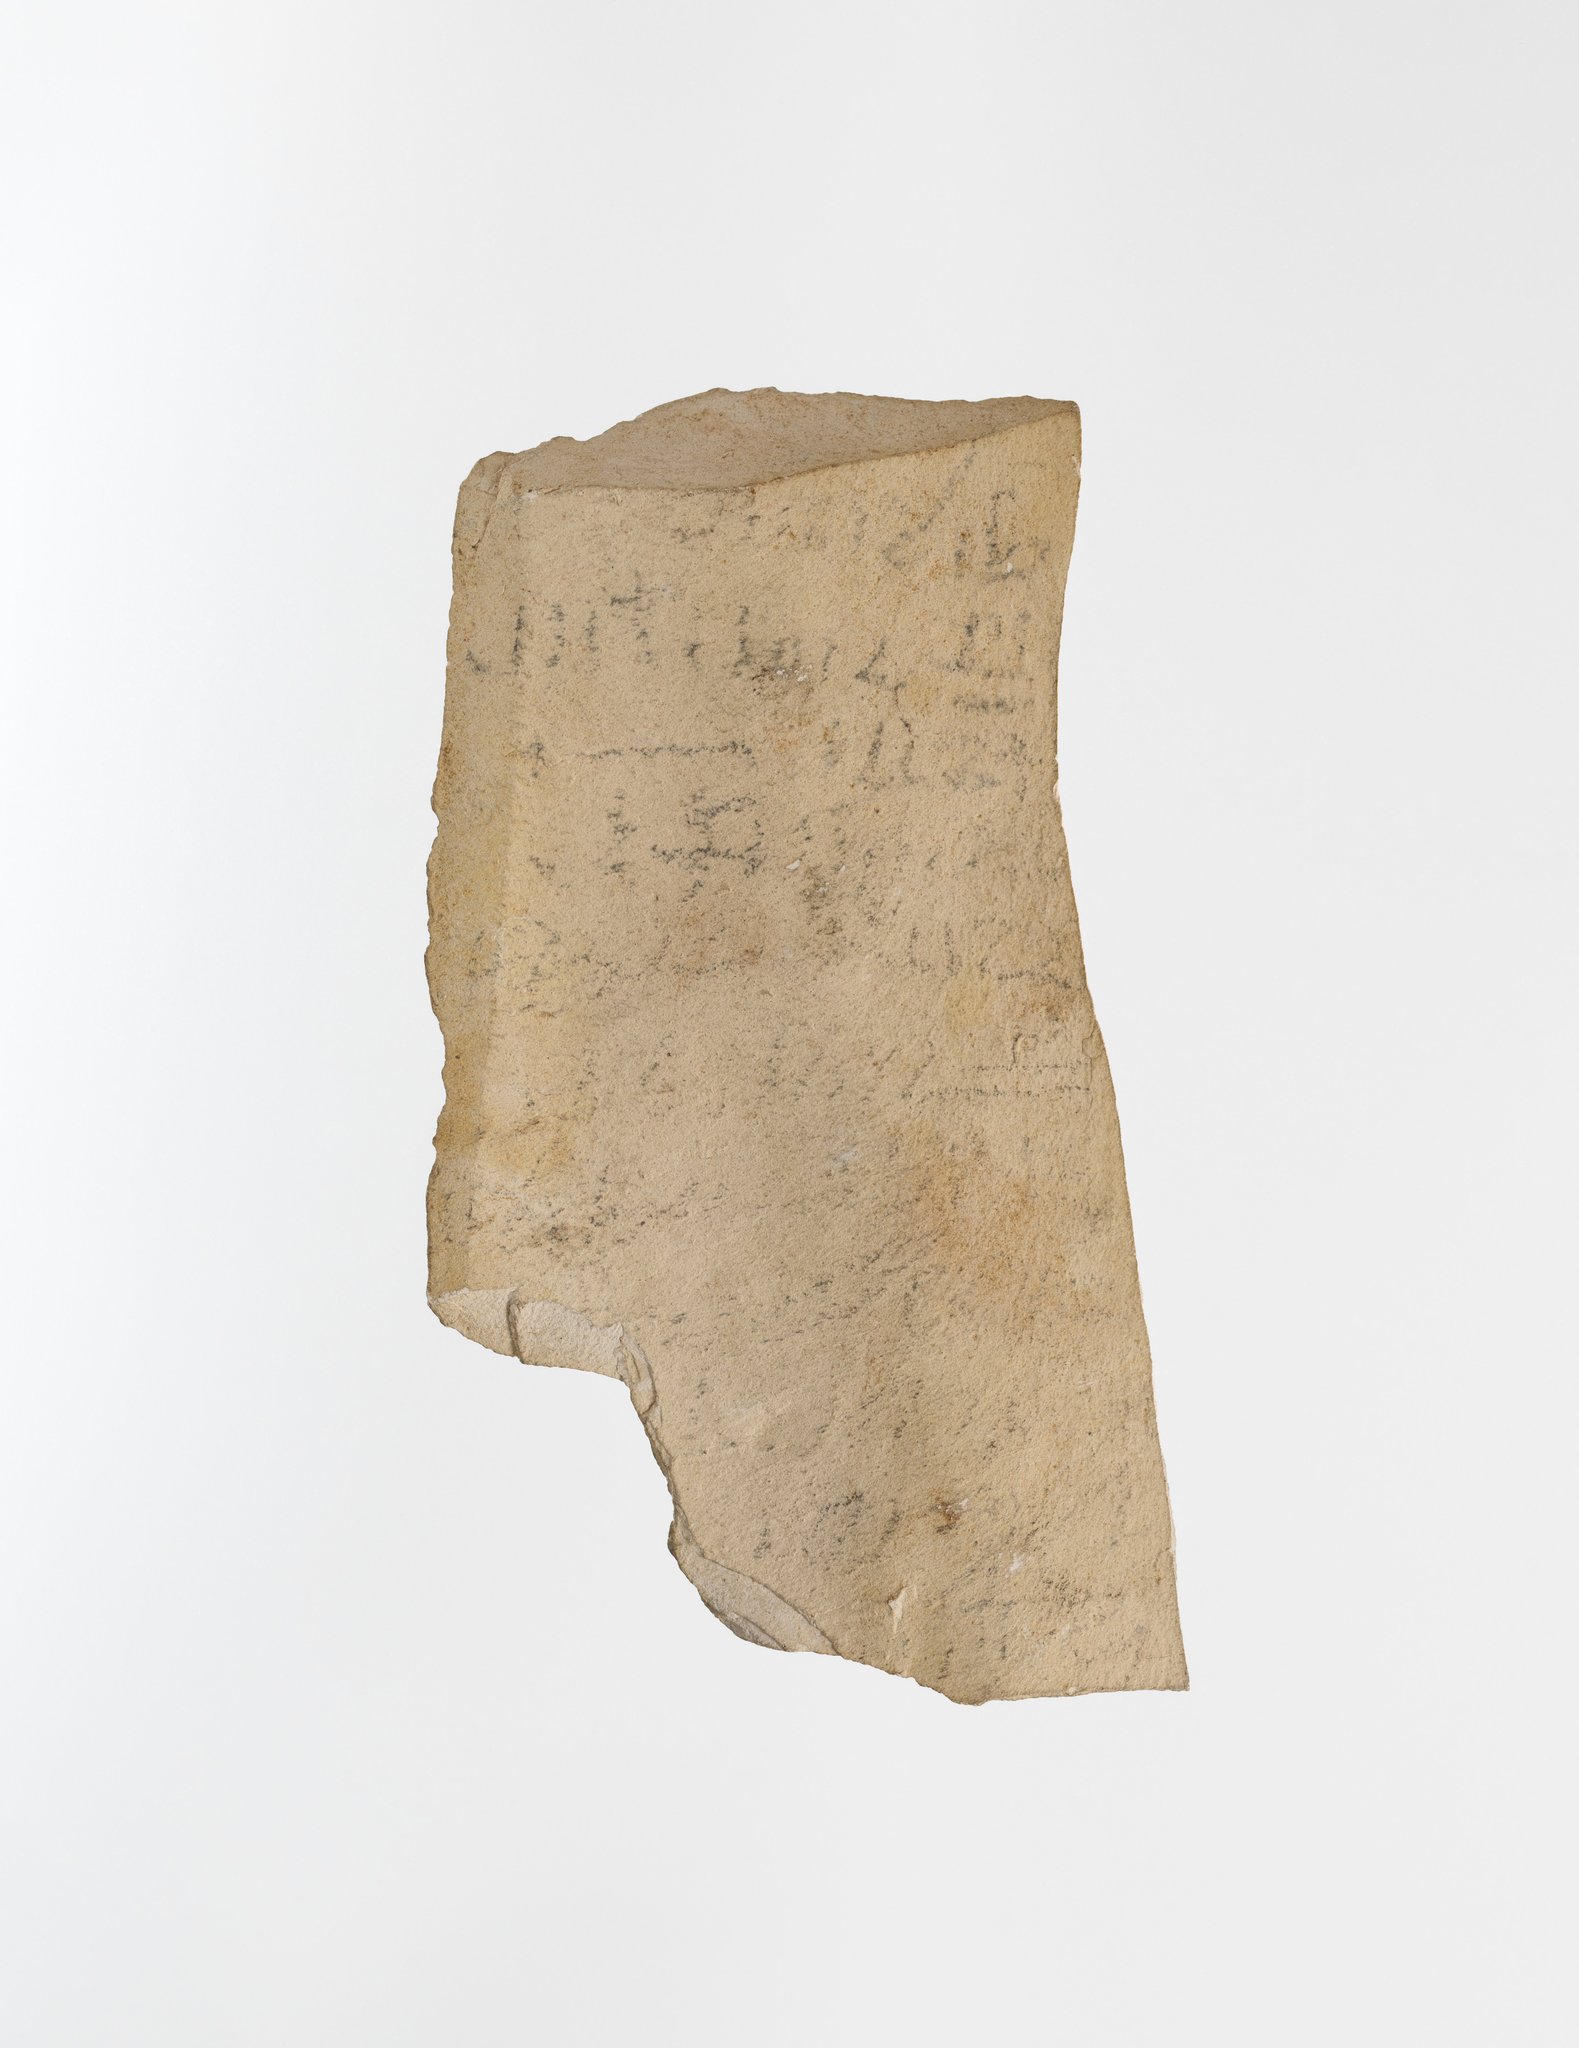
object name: ostracon, hieratic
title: Ostracon with hieratic inscription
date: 1295-525 BCE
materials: ink, limestone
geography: egypt